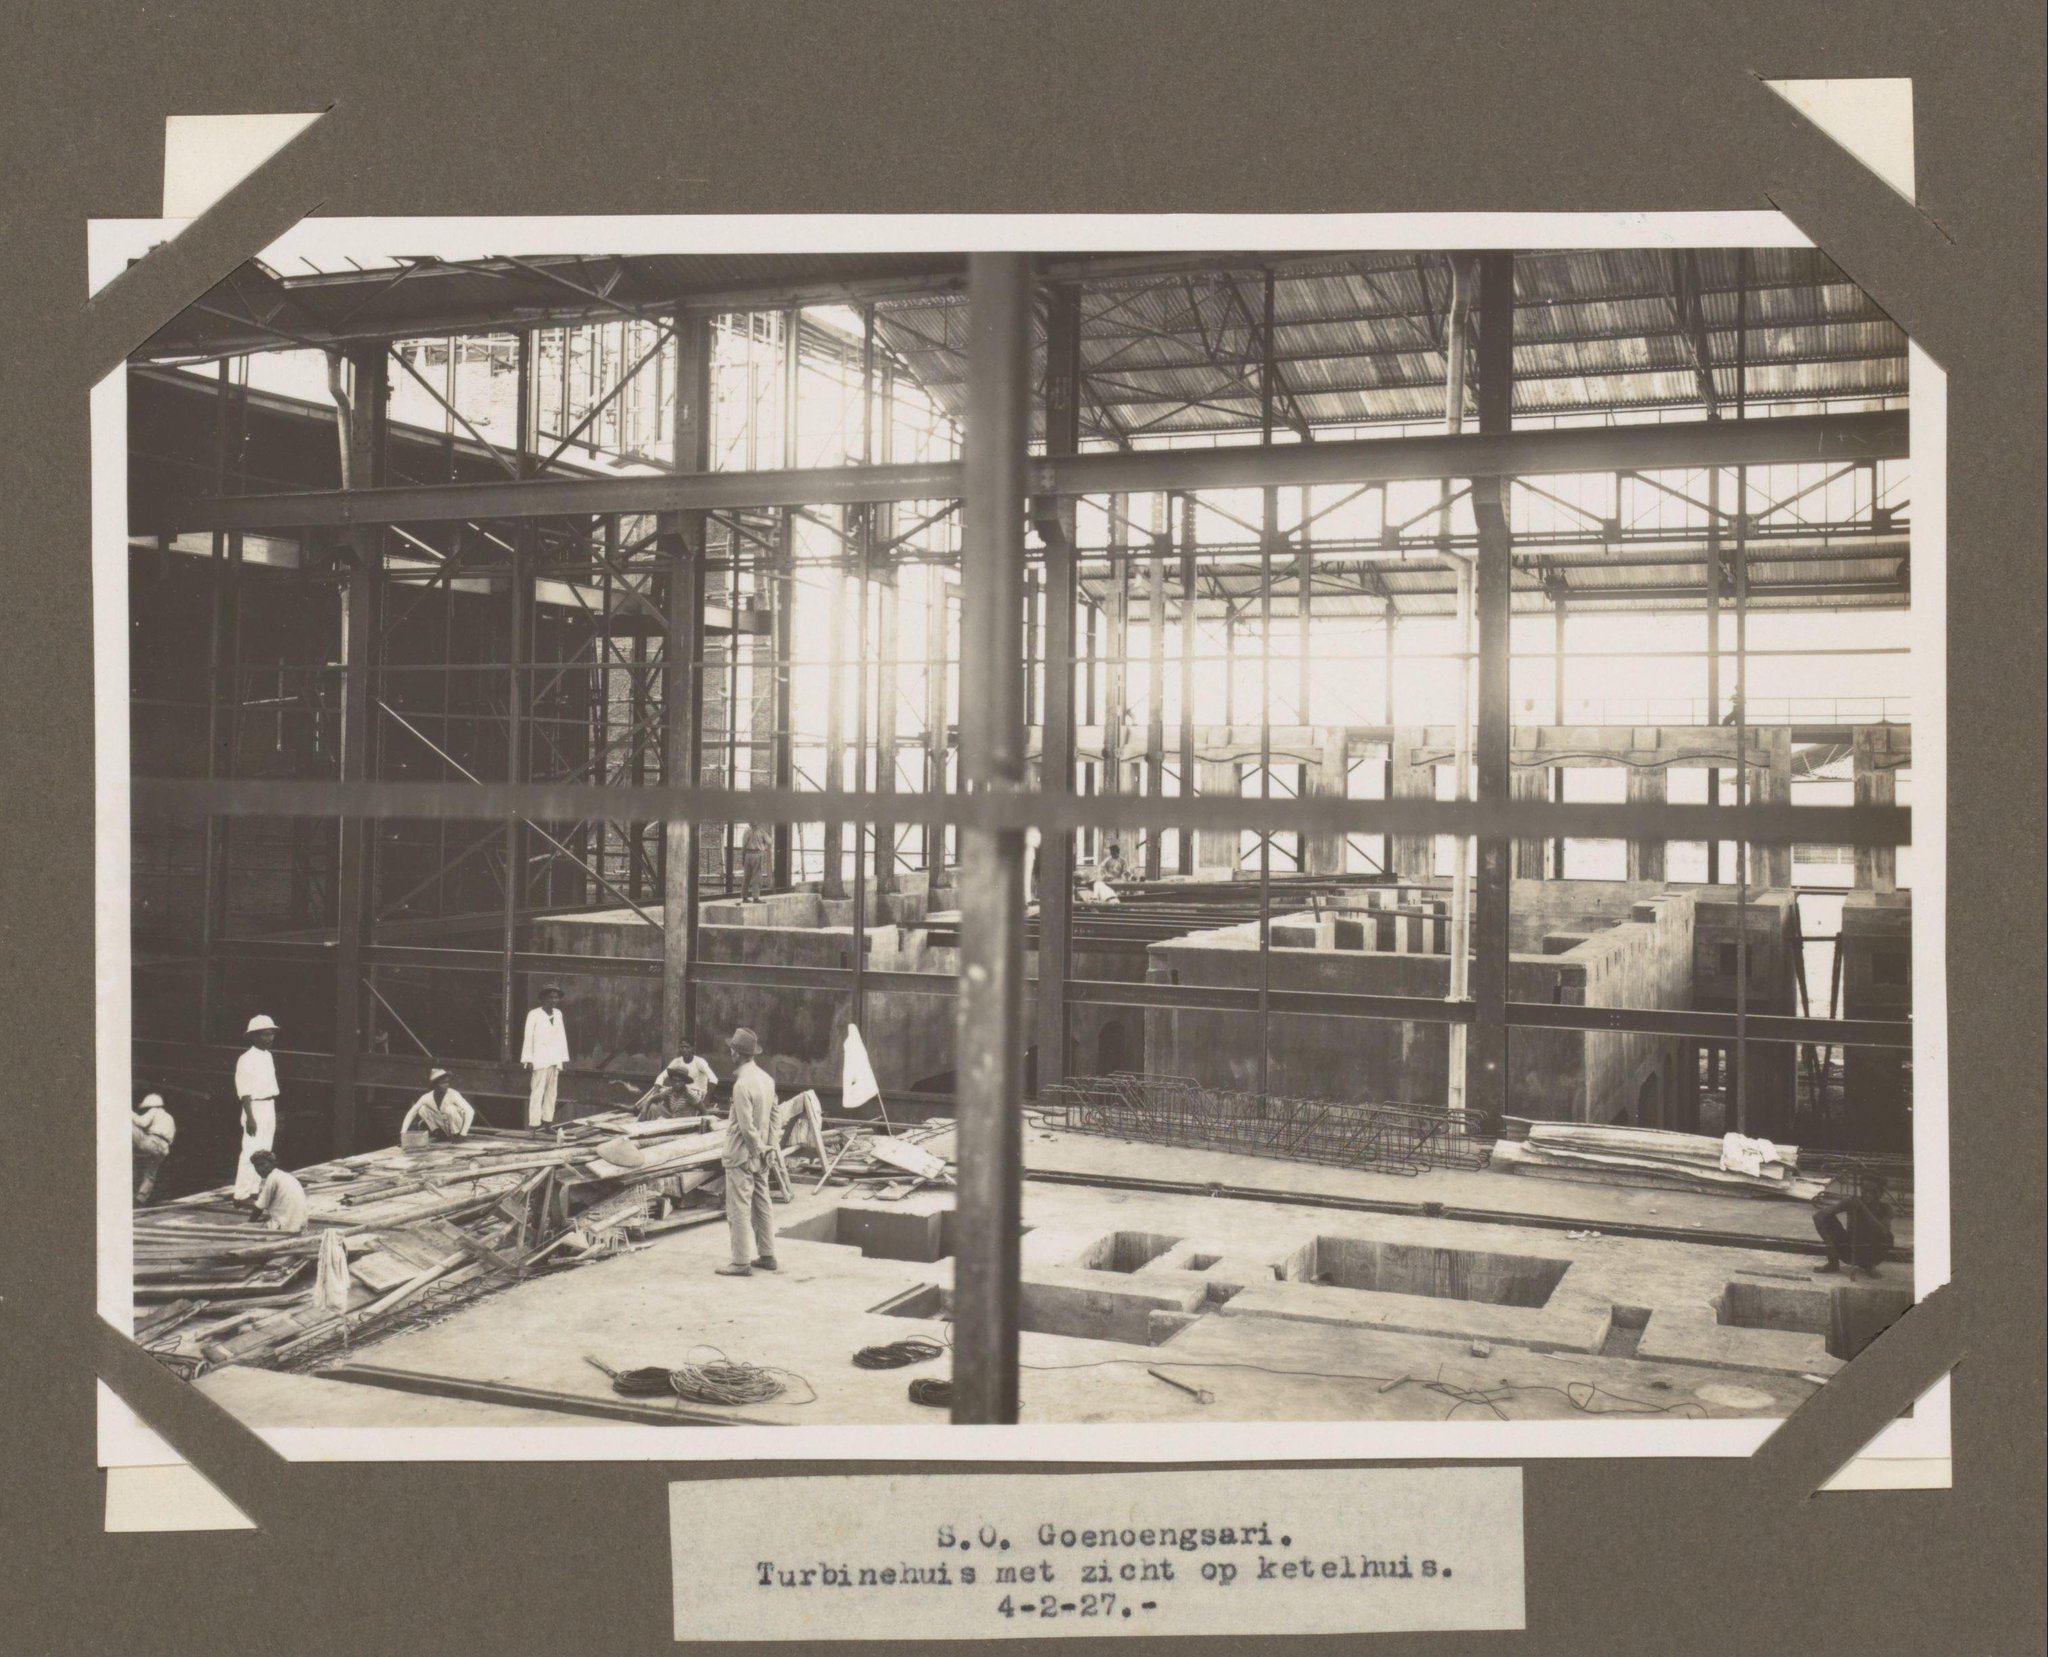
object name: photograph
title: S.O. Goenoengsari. Turbinehuis met zicht op ketelhuis. 4-2-27.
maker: Anonymous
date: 1902-1927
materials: photographic support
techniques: gelatin silver print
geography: east java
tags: colonial system, trade-company, factory-interior, machine shop, making the overground structures (~ building activities), (non-fruit) products of plants or trees: sugarcane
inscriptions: inscription: ‘S.O. Goenoengsari. Turbinehuis met zicht op ketelhuis. 4-2-27.’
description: Interieur van het turbinehuis in aanbouw, met bouwvakkers en opzichter, 4 februari 1927. Onderdeel van het fotoalbum met foto's van de opbouw van de suikerfabriek te Goenoengsari op Oost-Java door de Handels Vereniging Amsterdam 1926-1927.